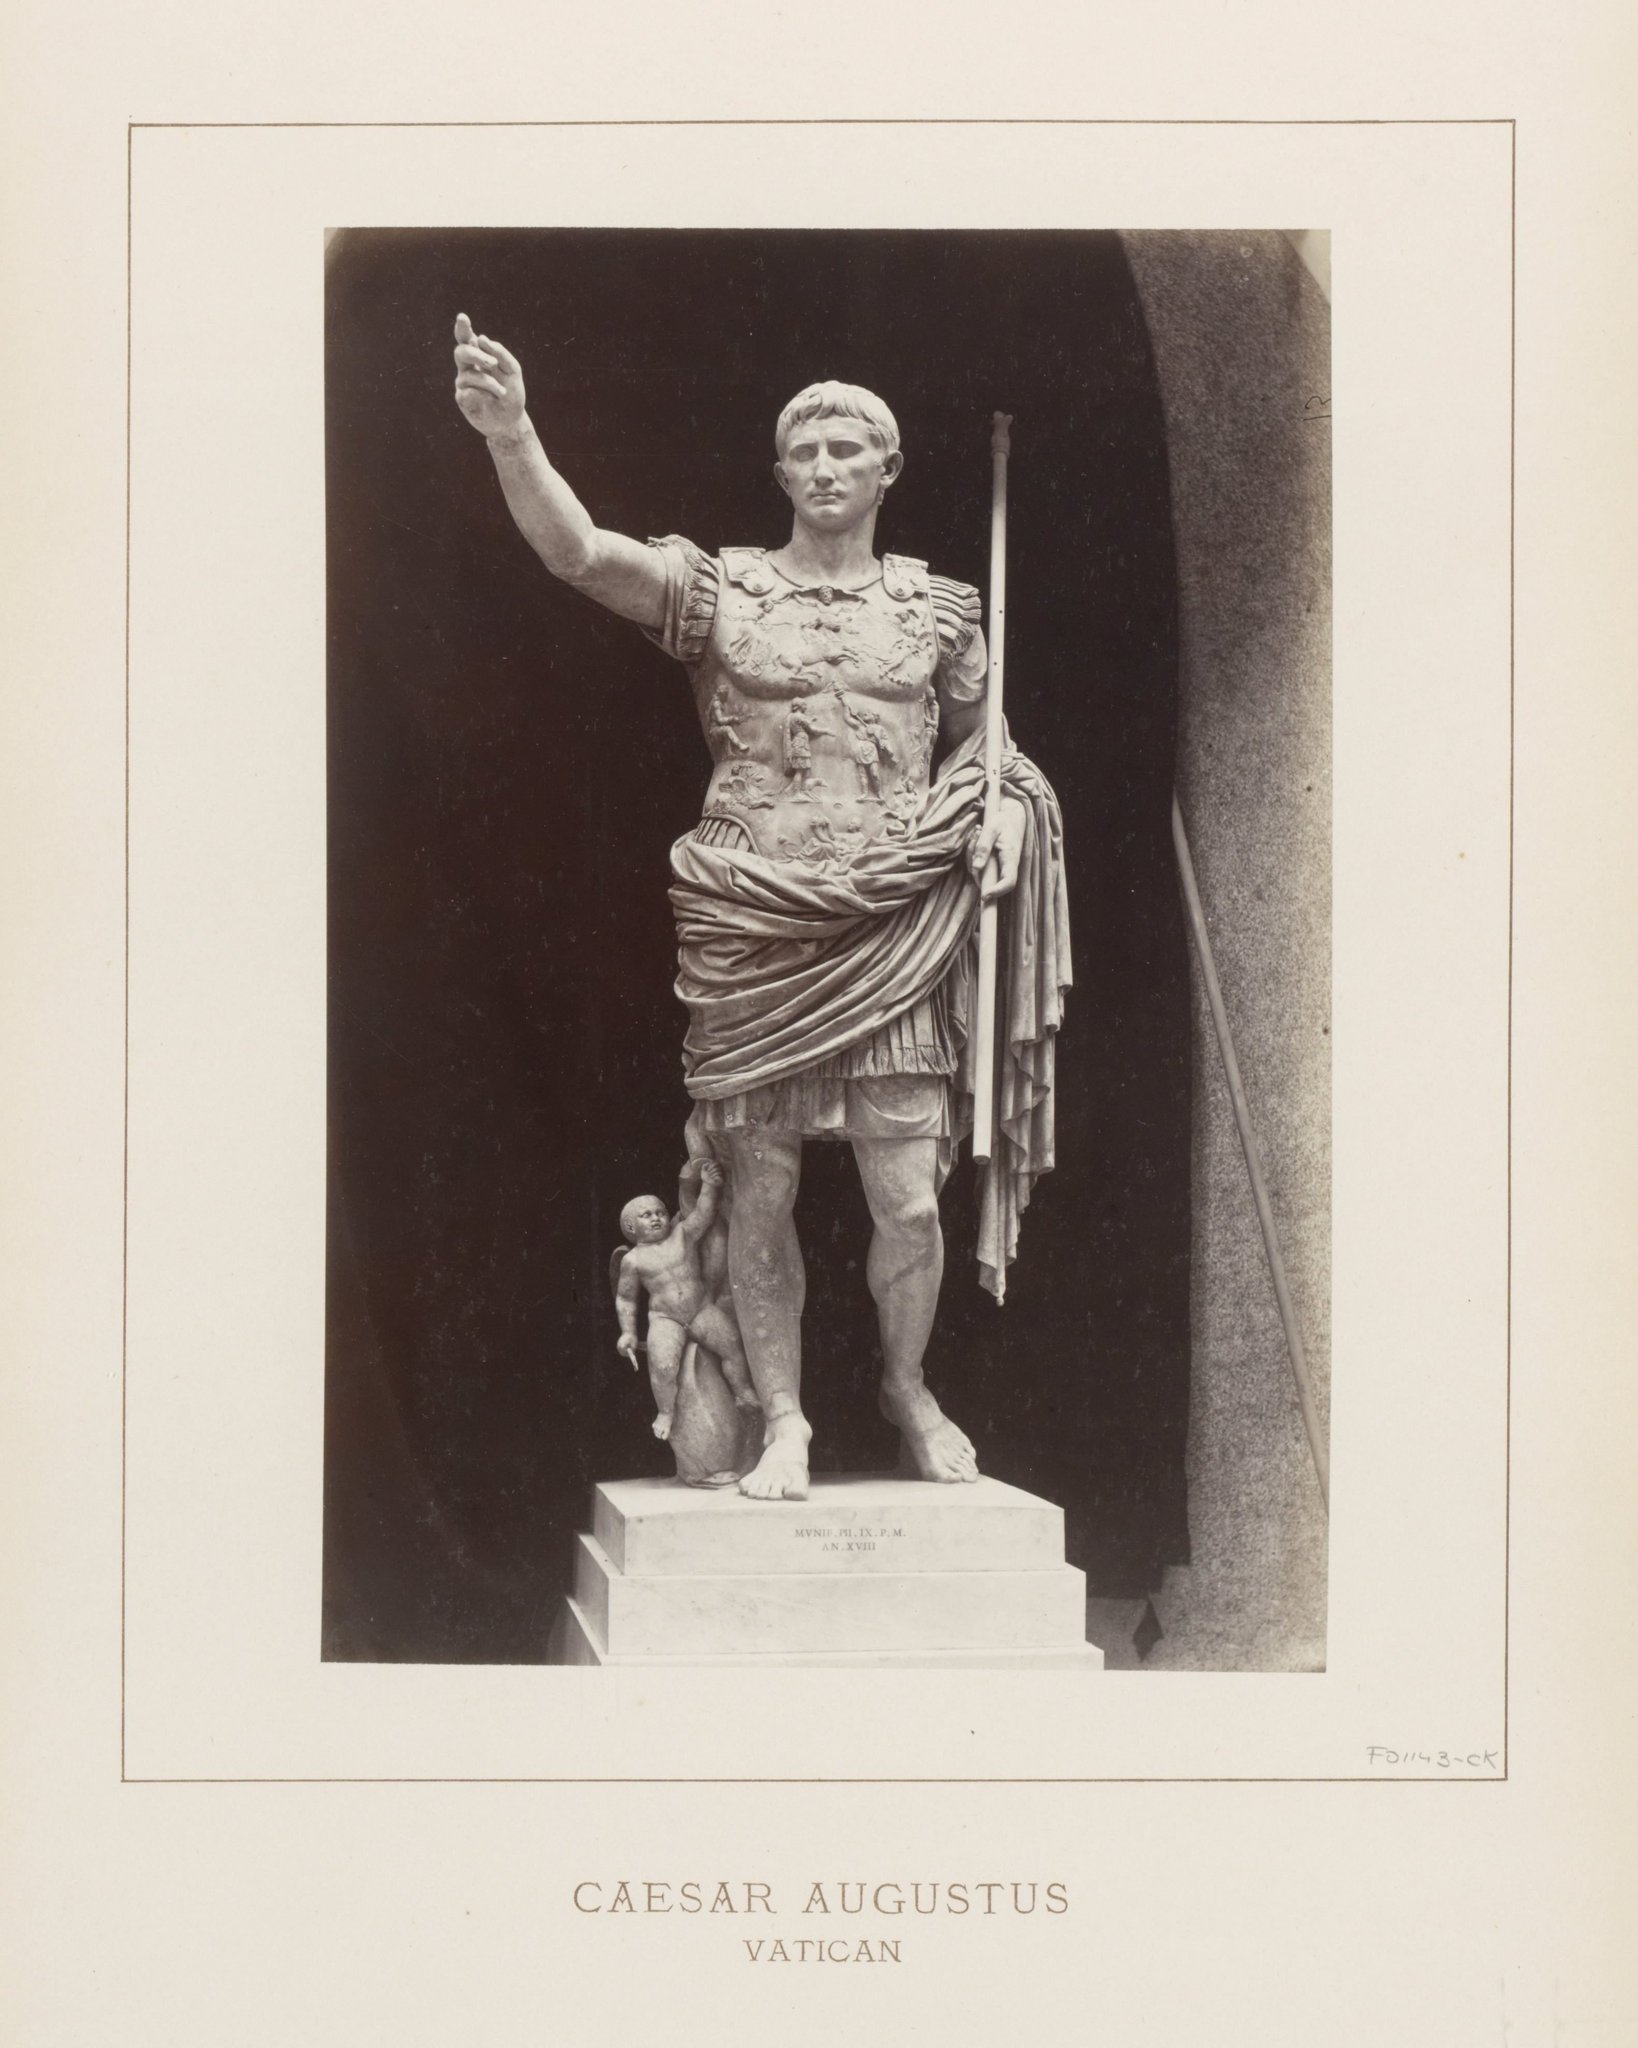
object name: photograph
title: Beeldhouwwerk Augustus van Prima Porta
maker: Anonymous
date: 1860-1900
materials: photographic support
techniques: albumen print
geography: vatican city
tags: piece of sculpture, reproduction of a piece of sculpture, ruler, sovereign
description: Onderdeel van Fotoalbum met opnames van bezienswaardigheden en kunstwerken in Rome.